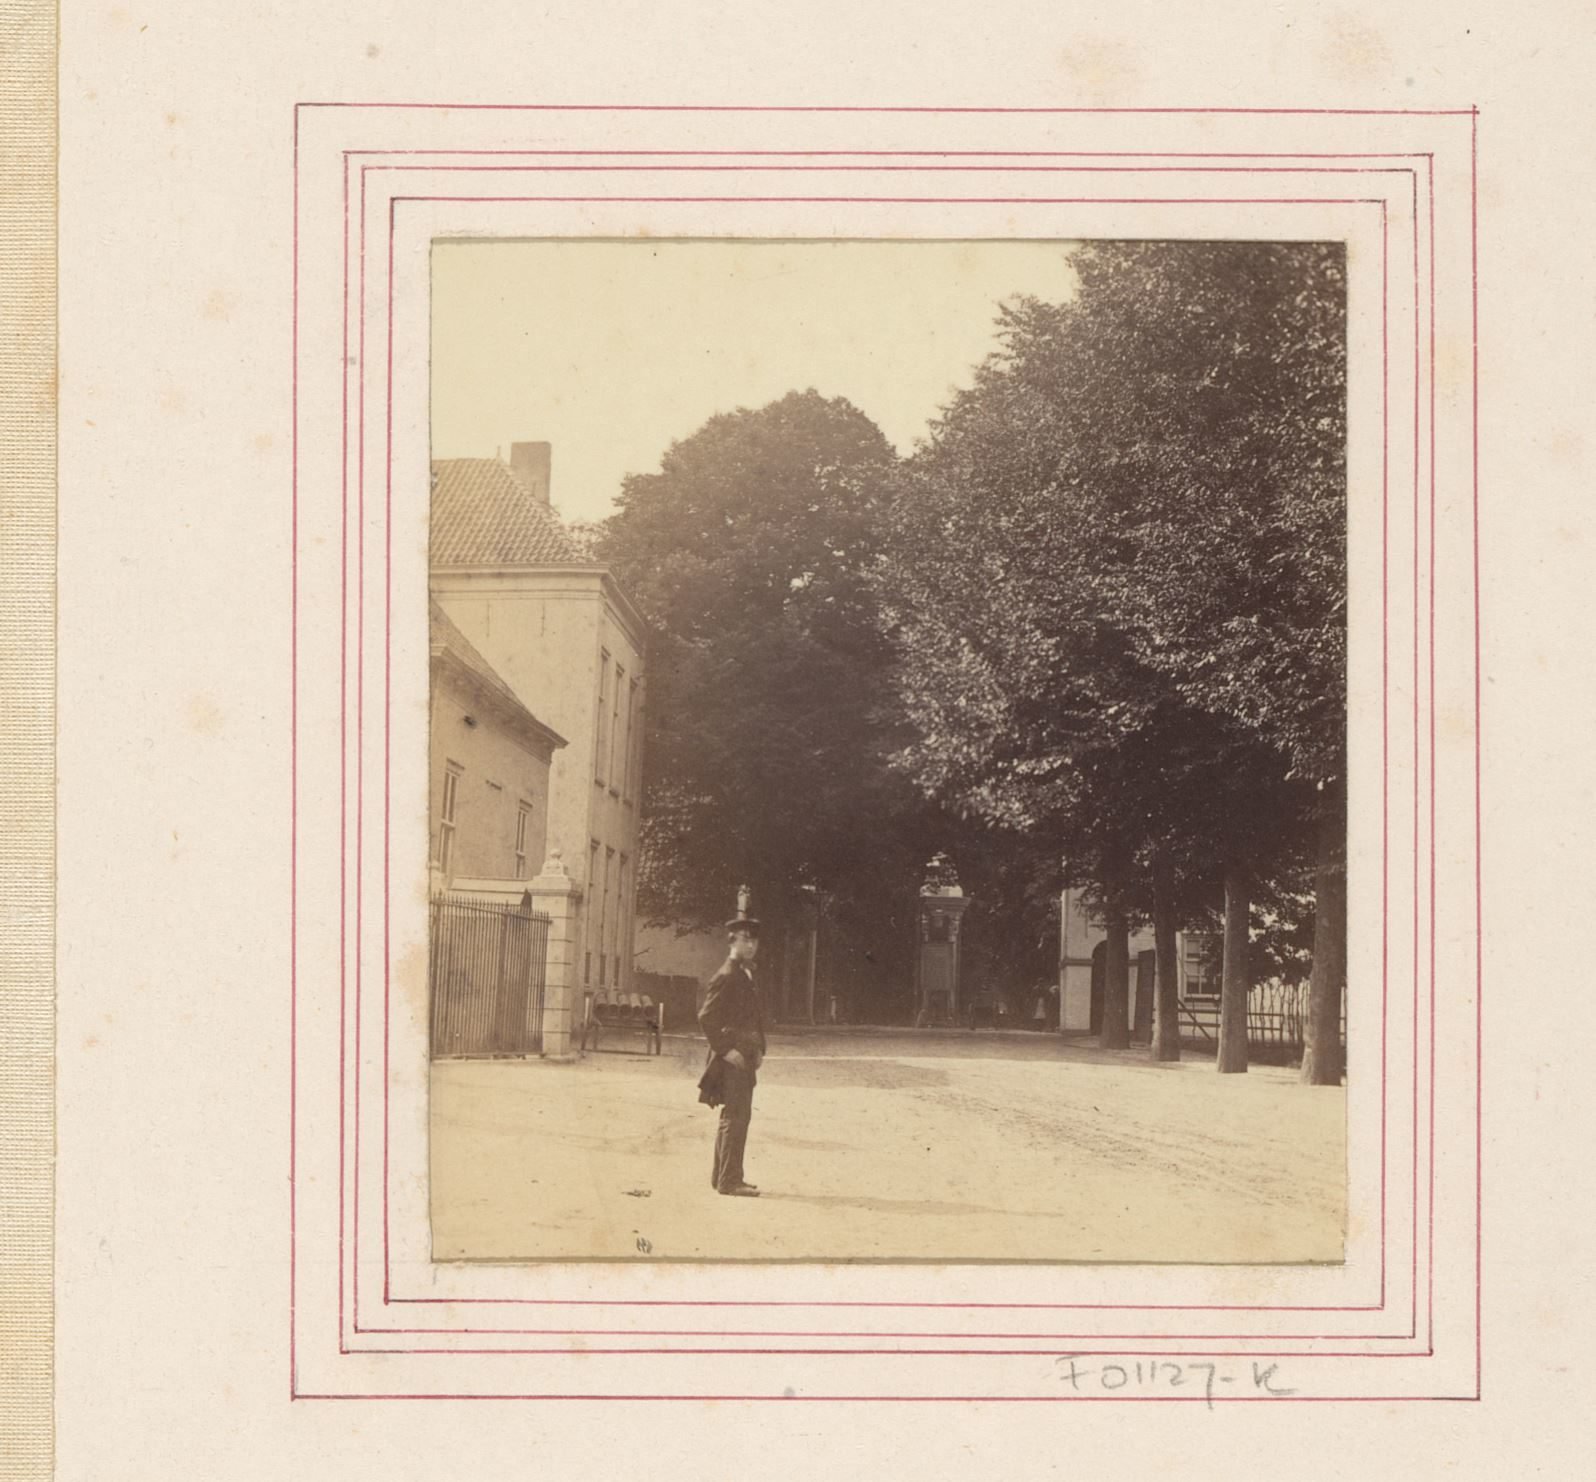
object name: photograph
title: Onbekende man poserend op de Scheveningseweg in Den Haag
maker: andries jager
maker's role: publisher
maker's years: 1825-1905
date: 1870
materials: photographic support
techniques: albumen print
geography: the hague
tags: adult man, street (+ city(-scape) with figures, staffage), the hague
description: Onbekende man poserend op de Scheveningseweg in Den Haag, ter hoogte van Paleis Buitenrust. Onderdeel van Album met foto's en litho's van bezienswaardigheden in Noord- en Zuid-Hollandse steden, schilderijen en klederdrachten.